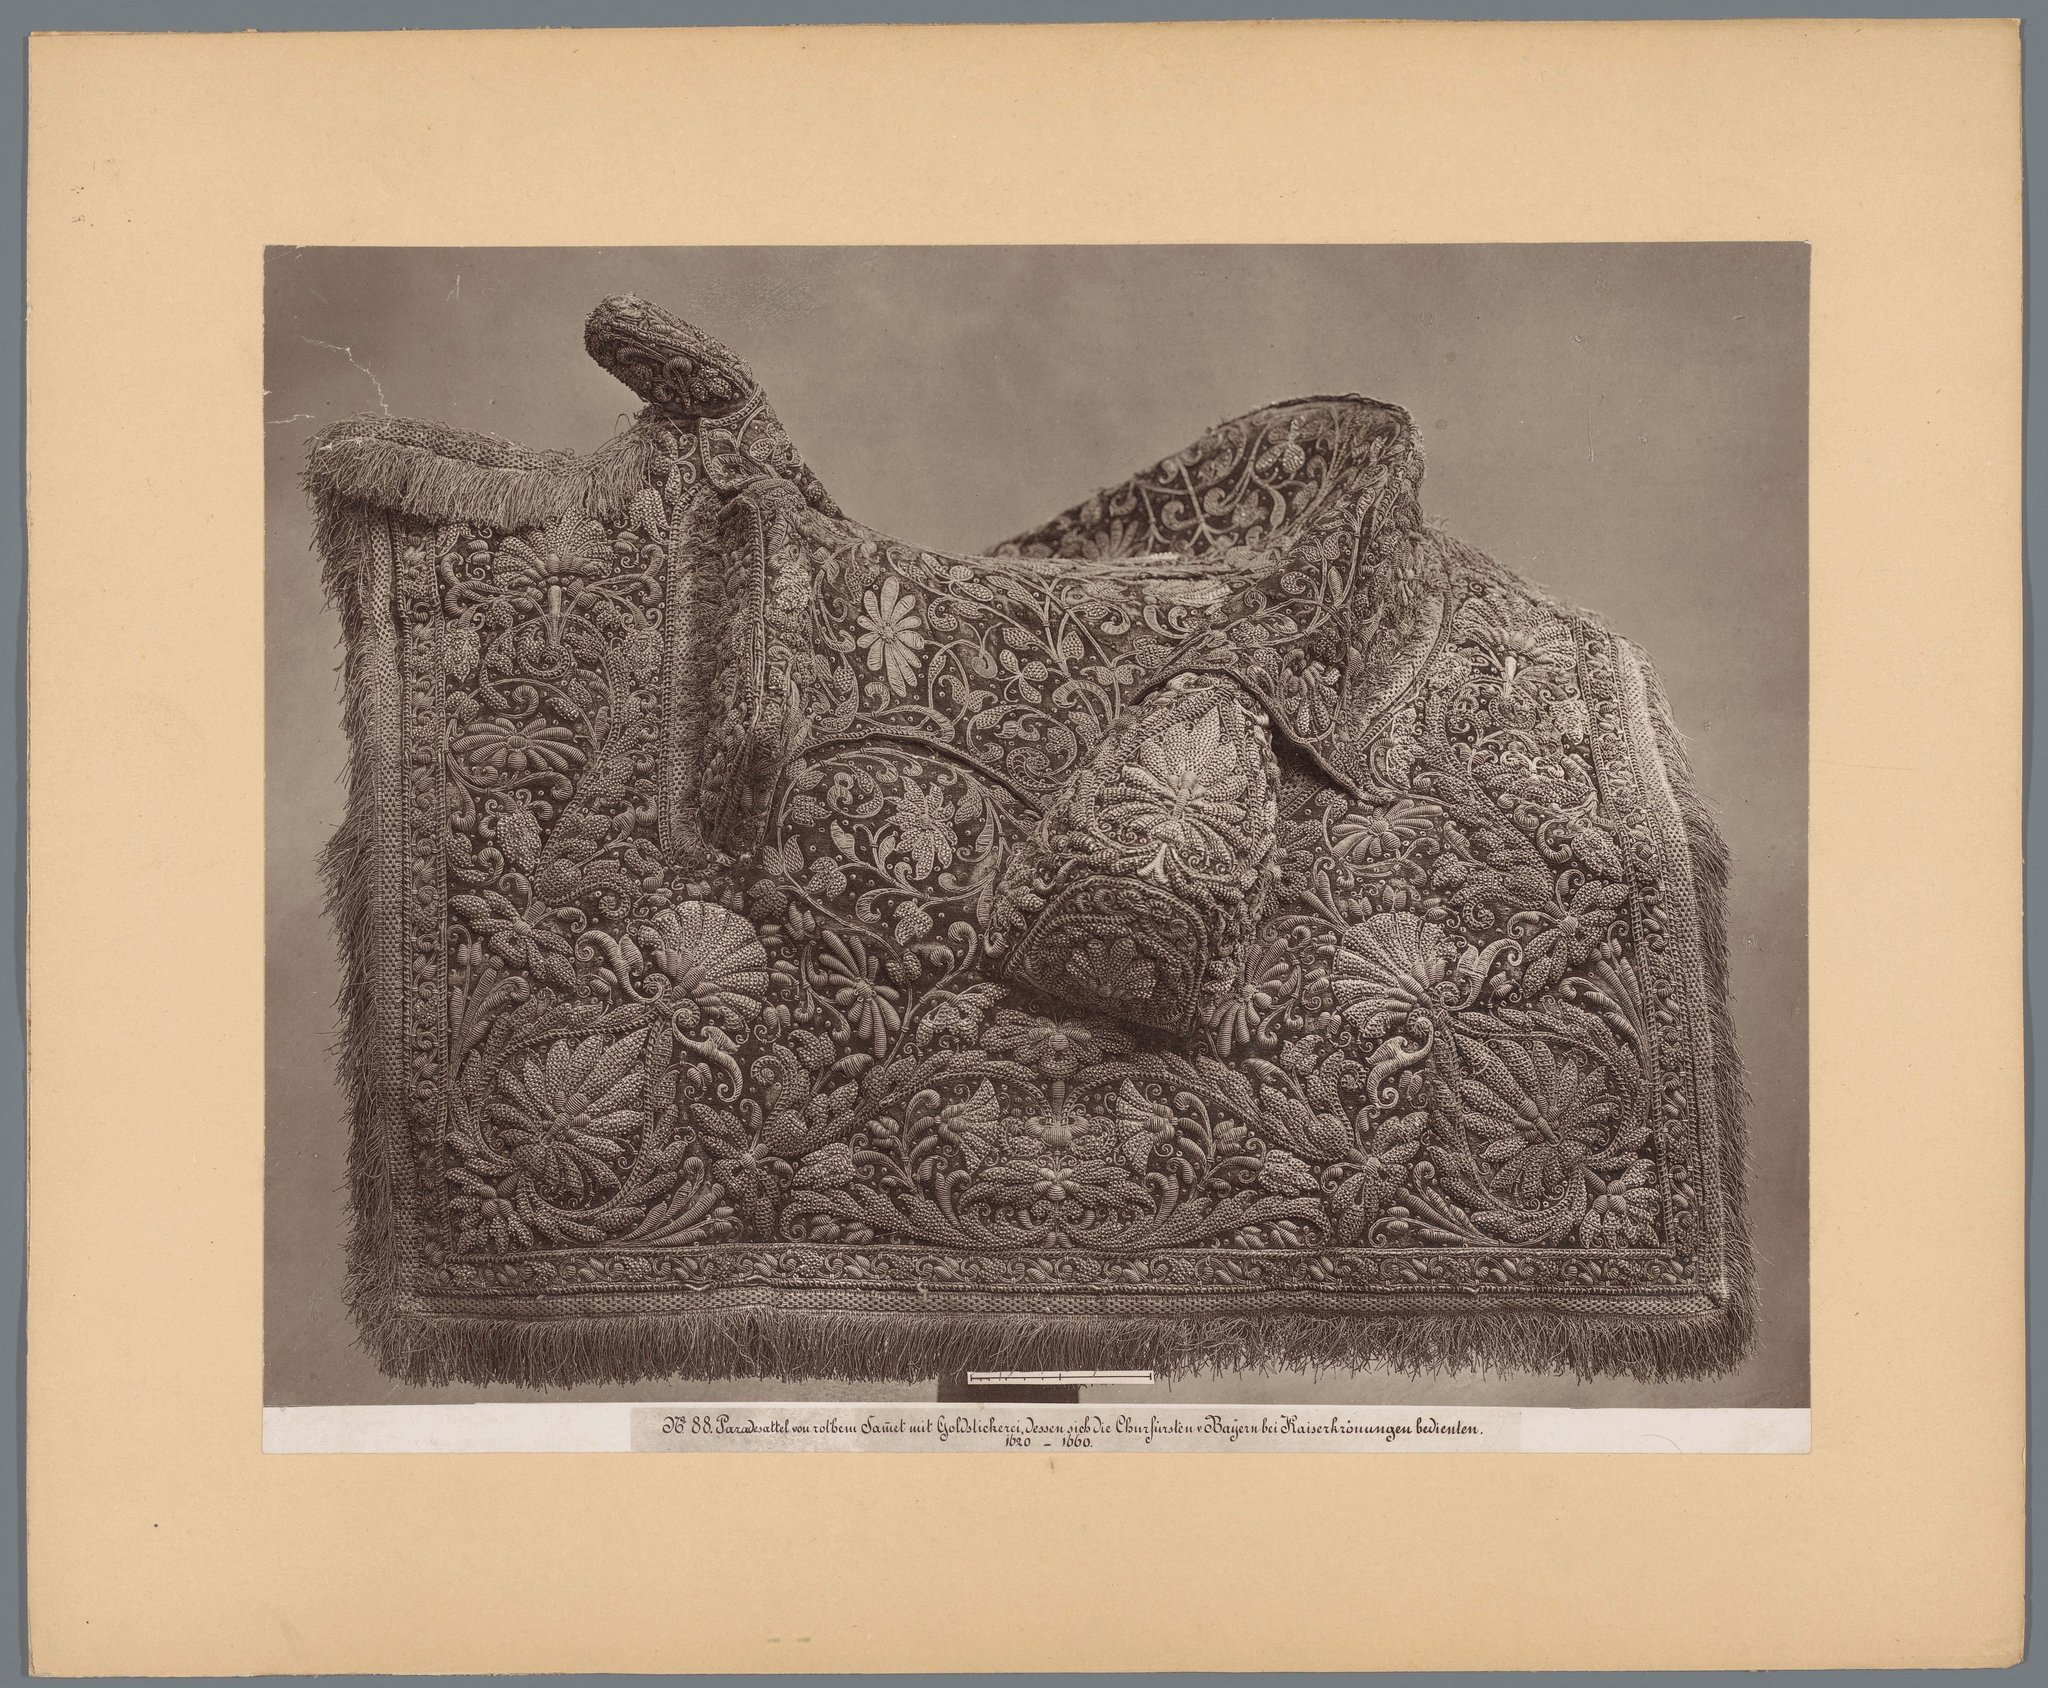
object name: photograph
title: Paradezadel, gebruikt door de keurvosten van Beieren bij de kroning van een keizer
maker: Anonymous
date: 1875-1900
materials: cardboard, paper, ink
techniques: photograph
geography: europe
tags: saddle, europe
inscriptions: inscription:, collector's mark: Lugt 3937